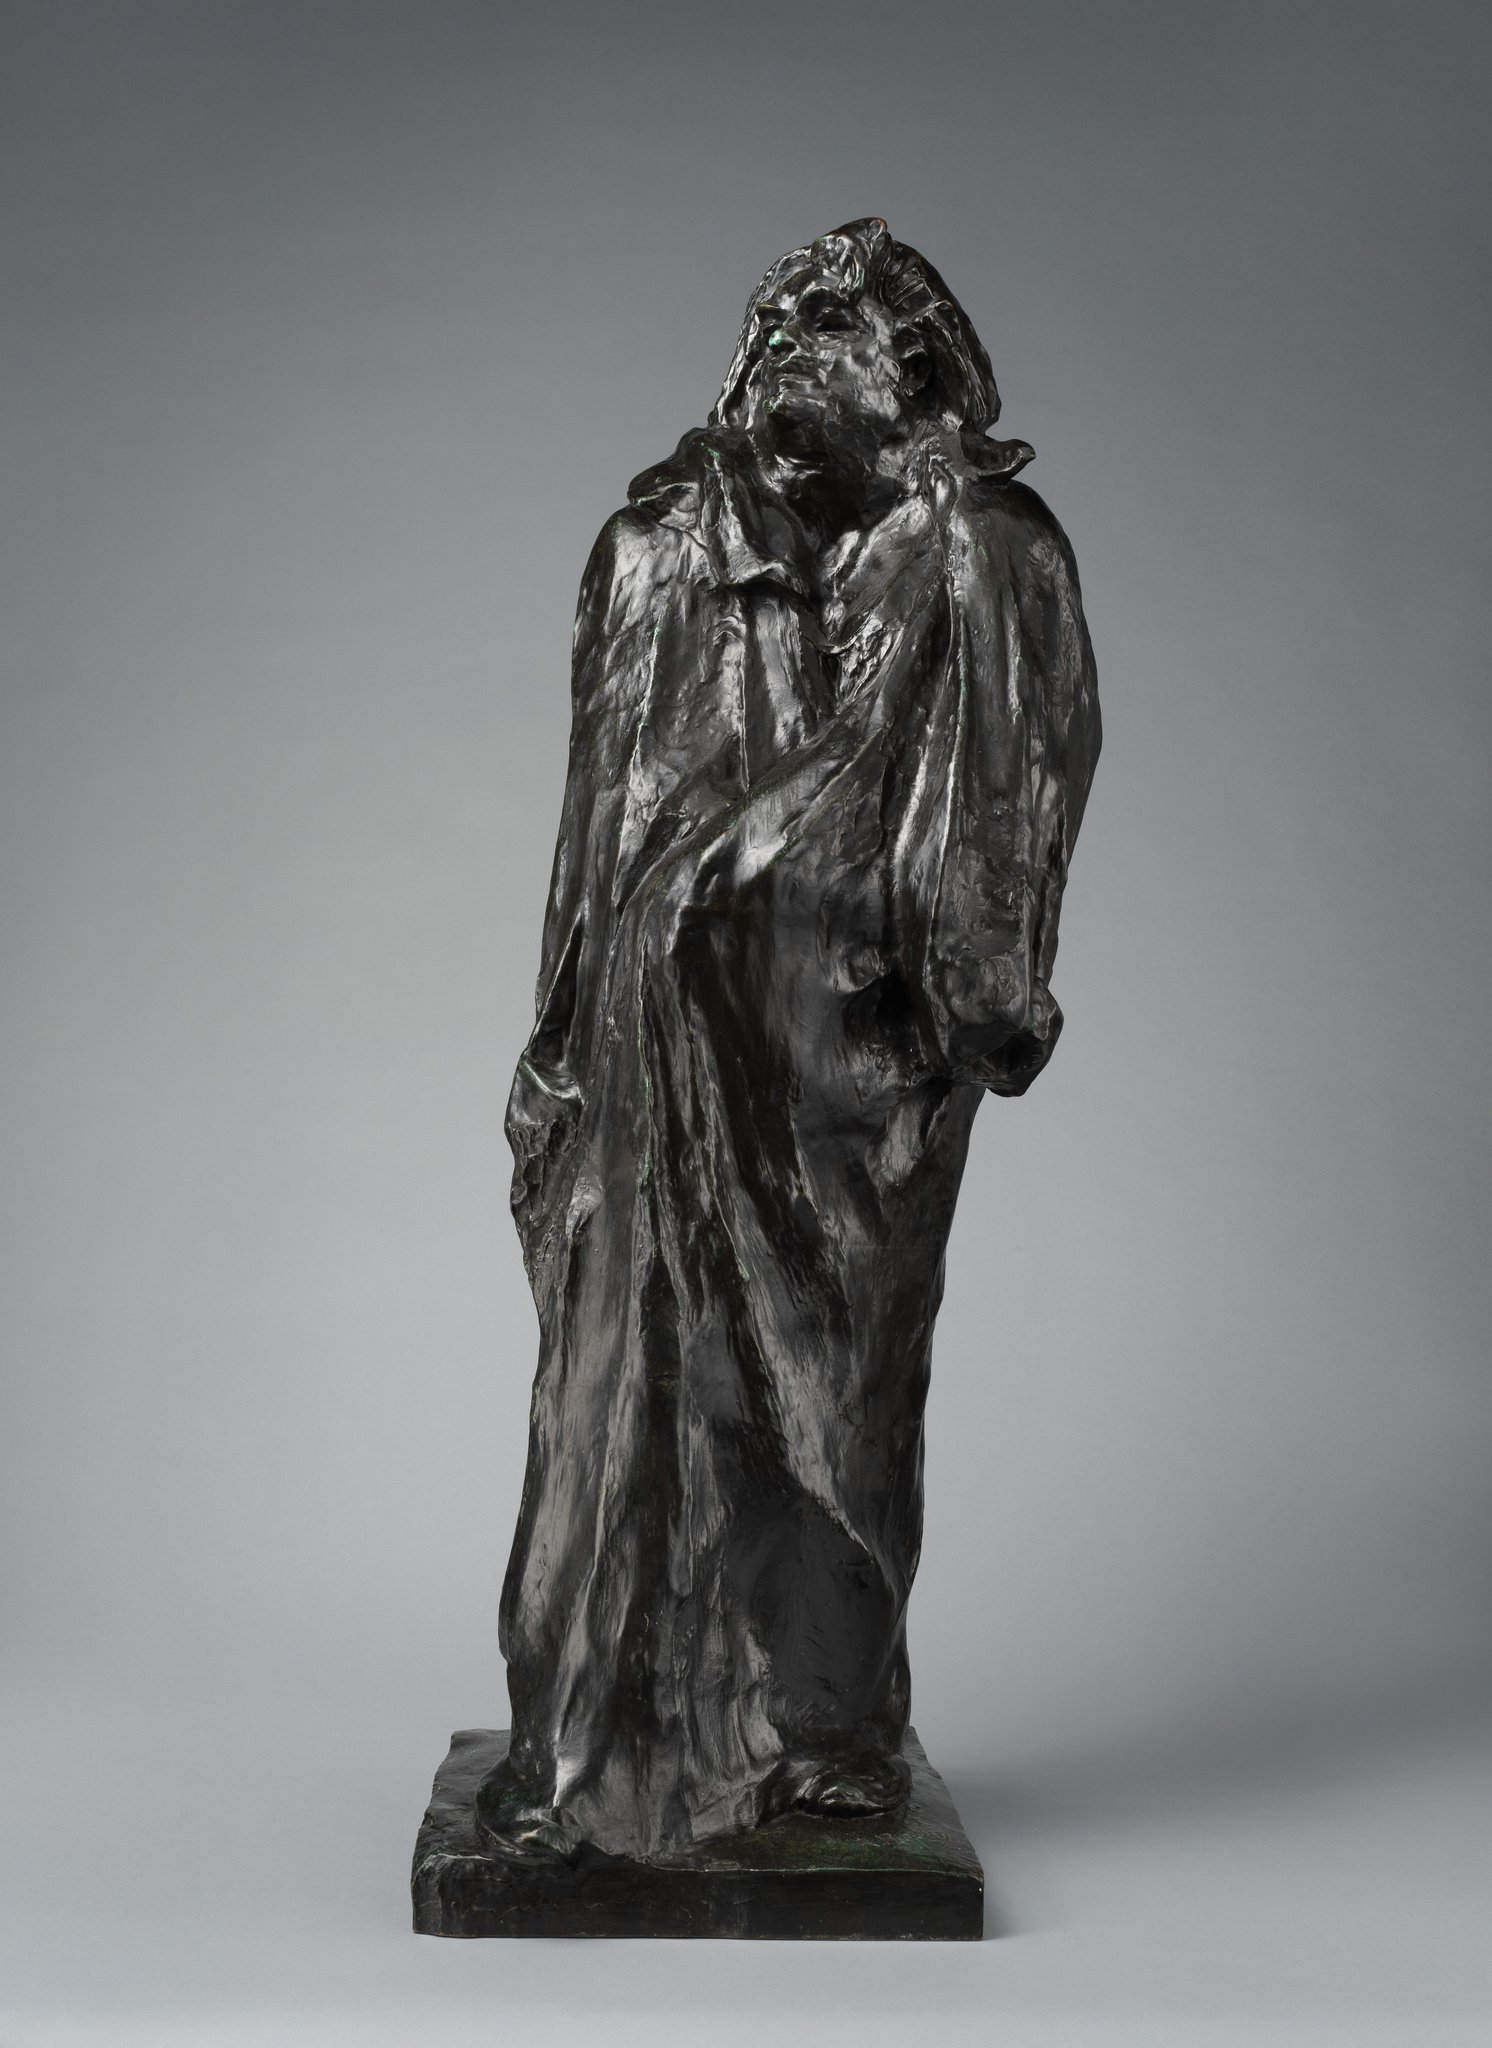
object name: statue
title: Final Study for the Monument to Balzac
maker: auguste rodin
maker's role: artist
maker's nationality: french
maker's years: 1840-1917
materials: bronze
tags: men,authors